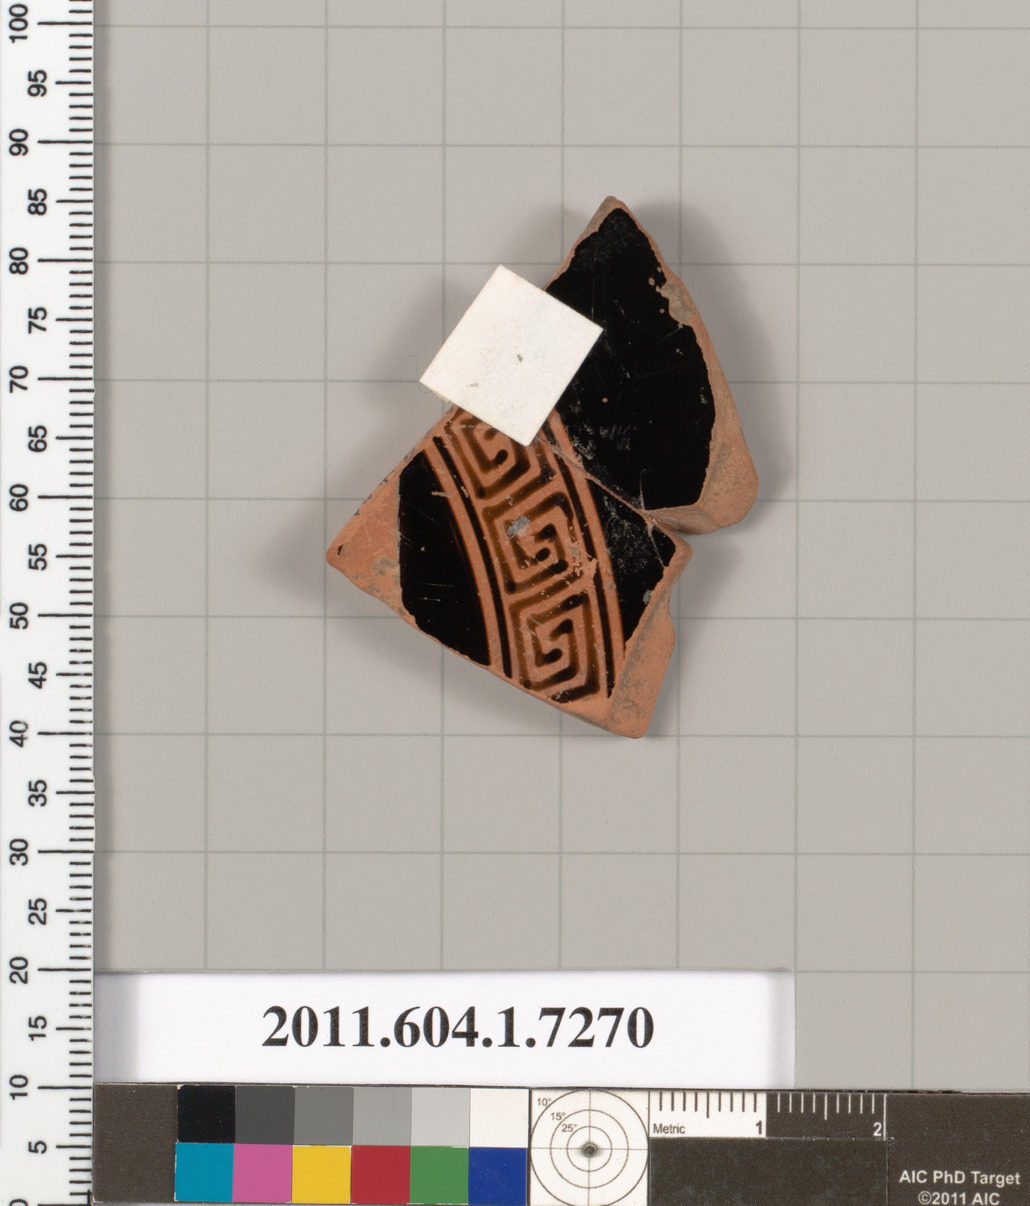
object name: kylix fragment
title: Terracotta fragment of a kylix (drinking cup)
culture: greek, attic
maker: makron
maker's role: artist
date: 500-480 BCE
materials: terracotta